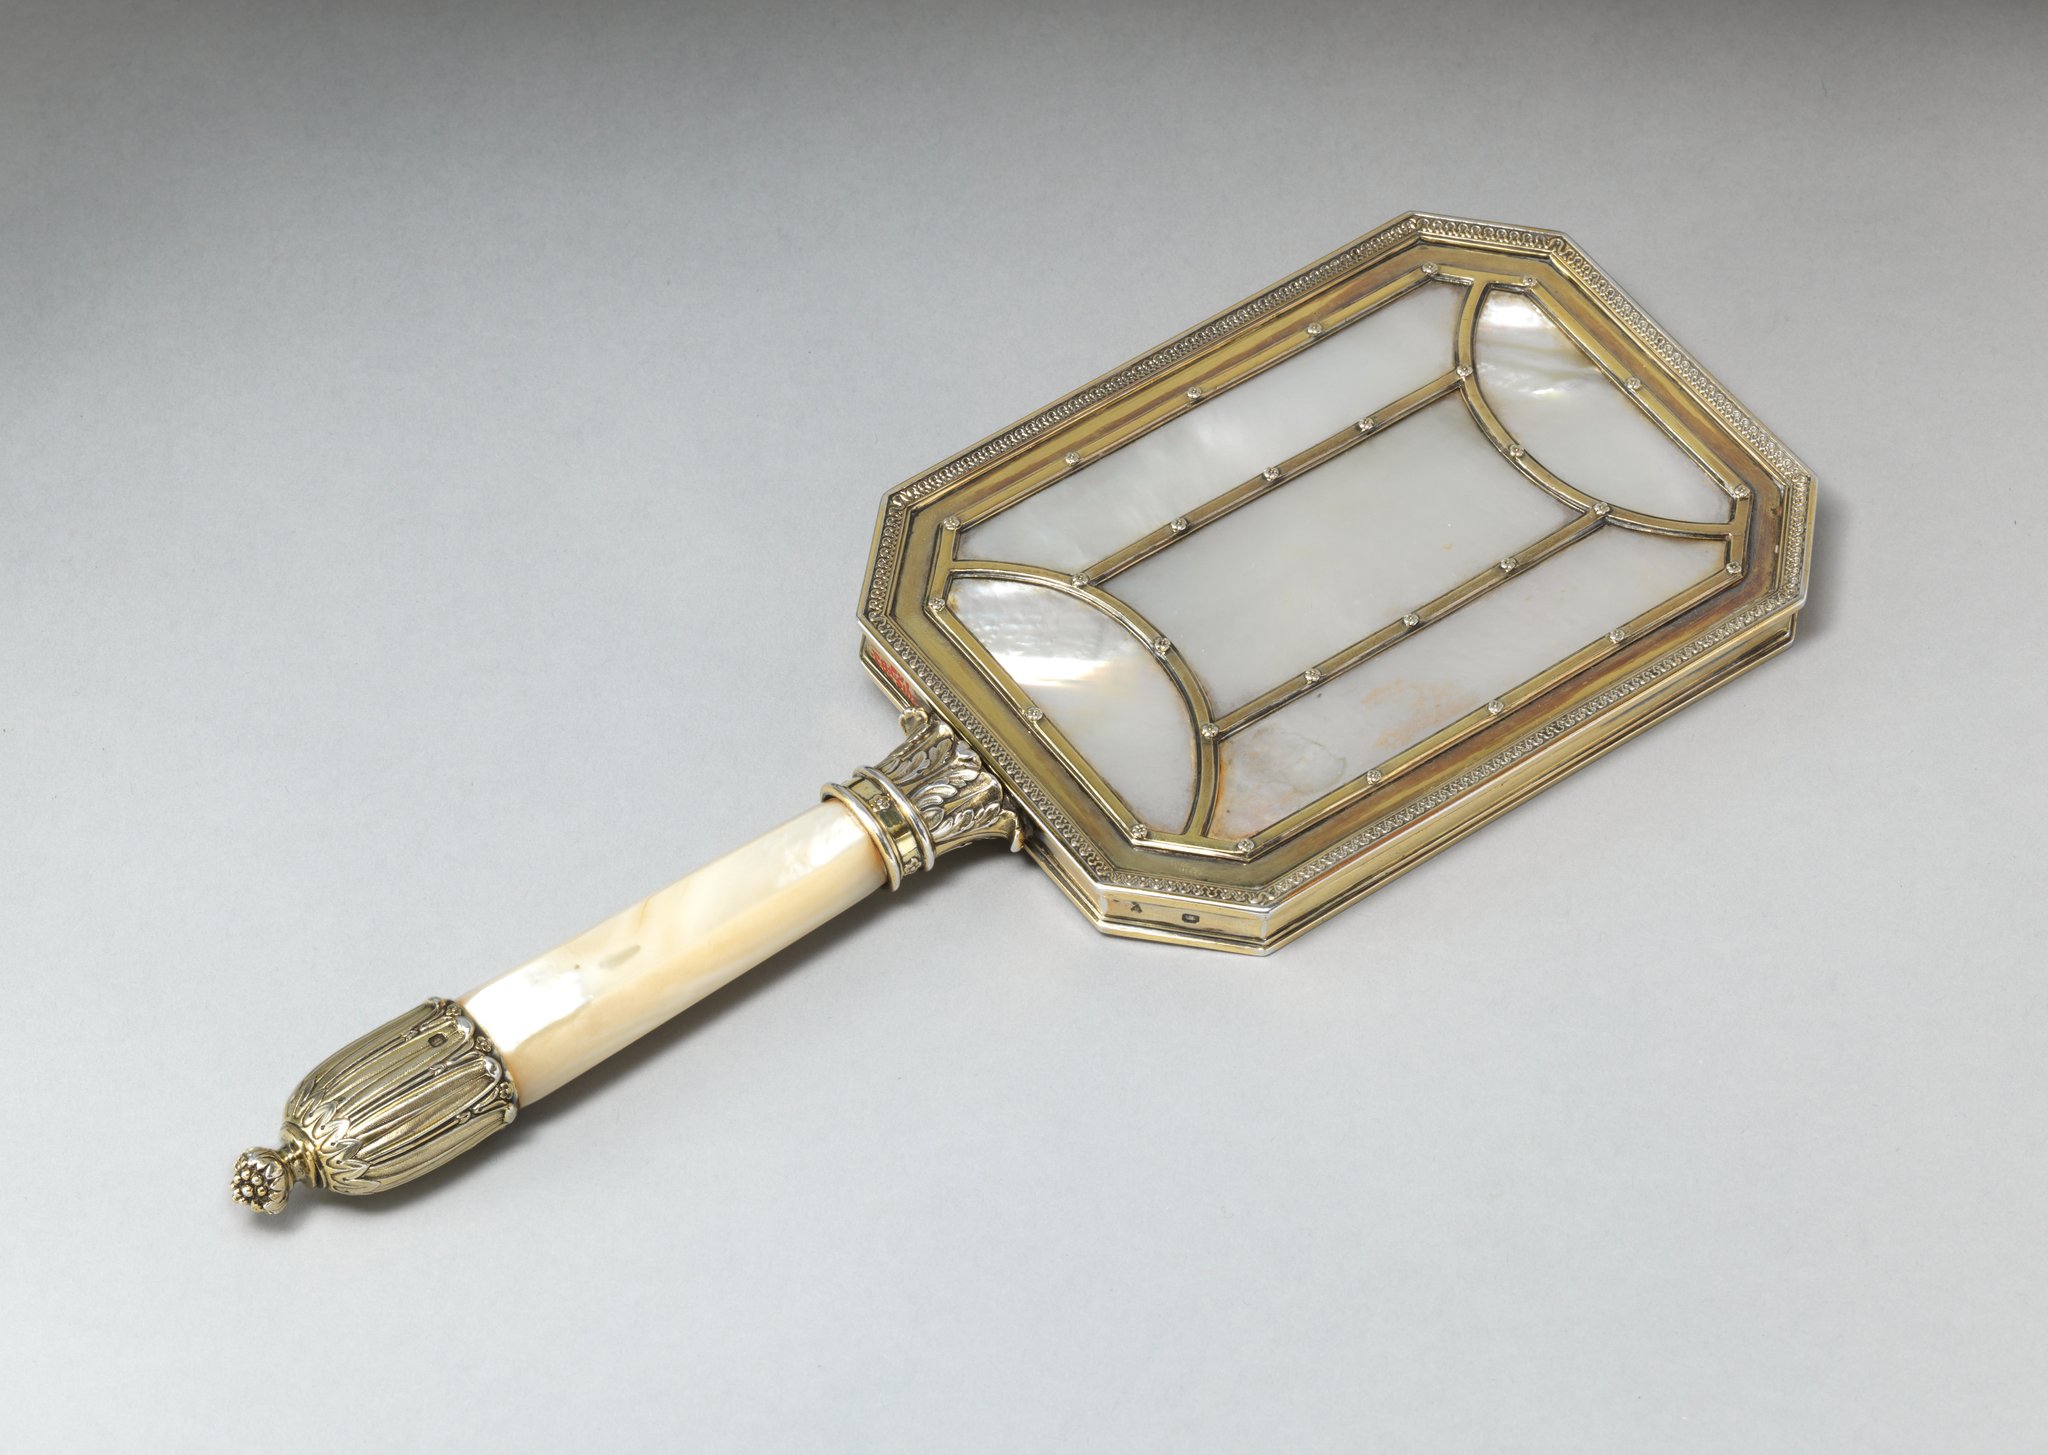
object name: hand mirror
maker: andré aucoc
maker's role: maker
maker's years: 1825-1925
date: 1887-1911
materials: mother of pearl, silver gilt